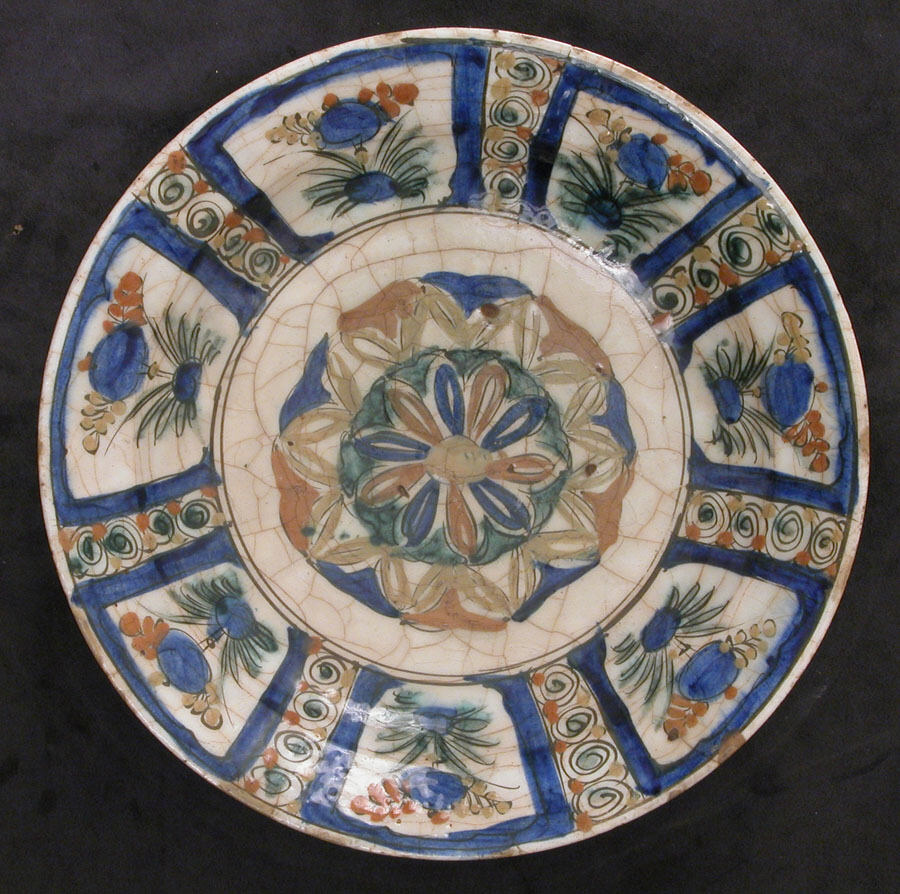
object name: dish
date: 1601-1700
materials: stonepaste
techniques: painting, underglaze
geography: iran